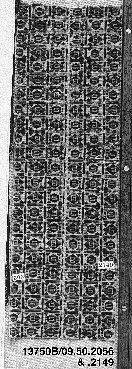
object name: textile fragment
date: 1801-1900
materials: linen, metal thread, silk, velvet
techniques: brocade, voiding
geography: india